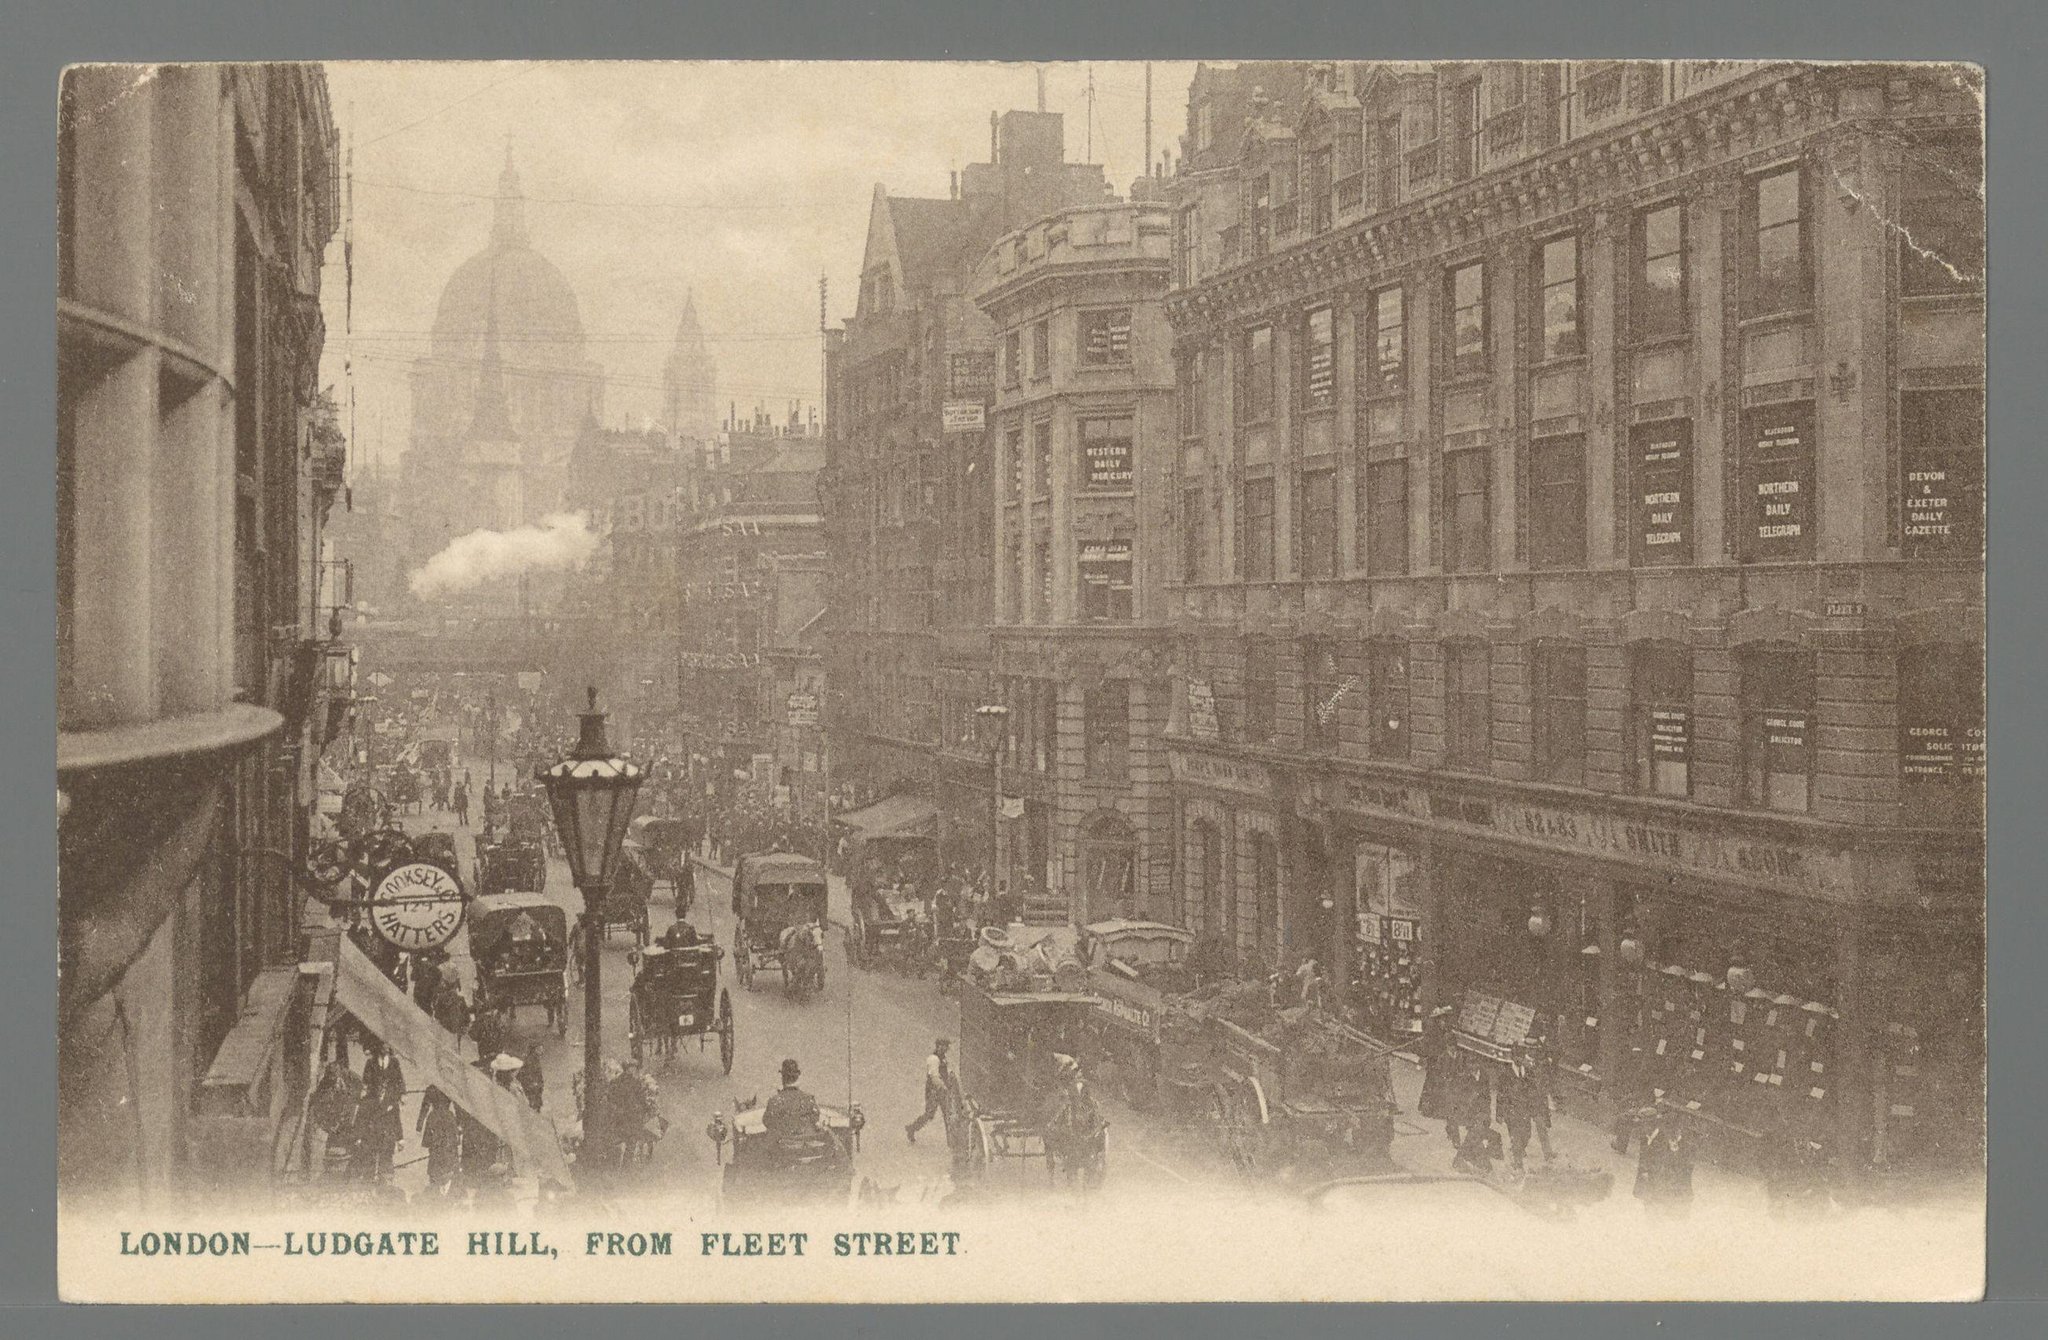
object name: photomechanical print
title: LESCO Series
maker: Anonymous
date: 1902-1906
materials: cardboard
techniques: photograph, writing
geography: london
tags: diligence, omnibus, horse-tram, street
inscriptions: postage stamp